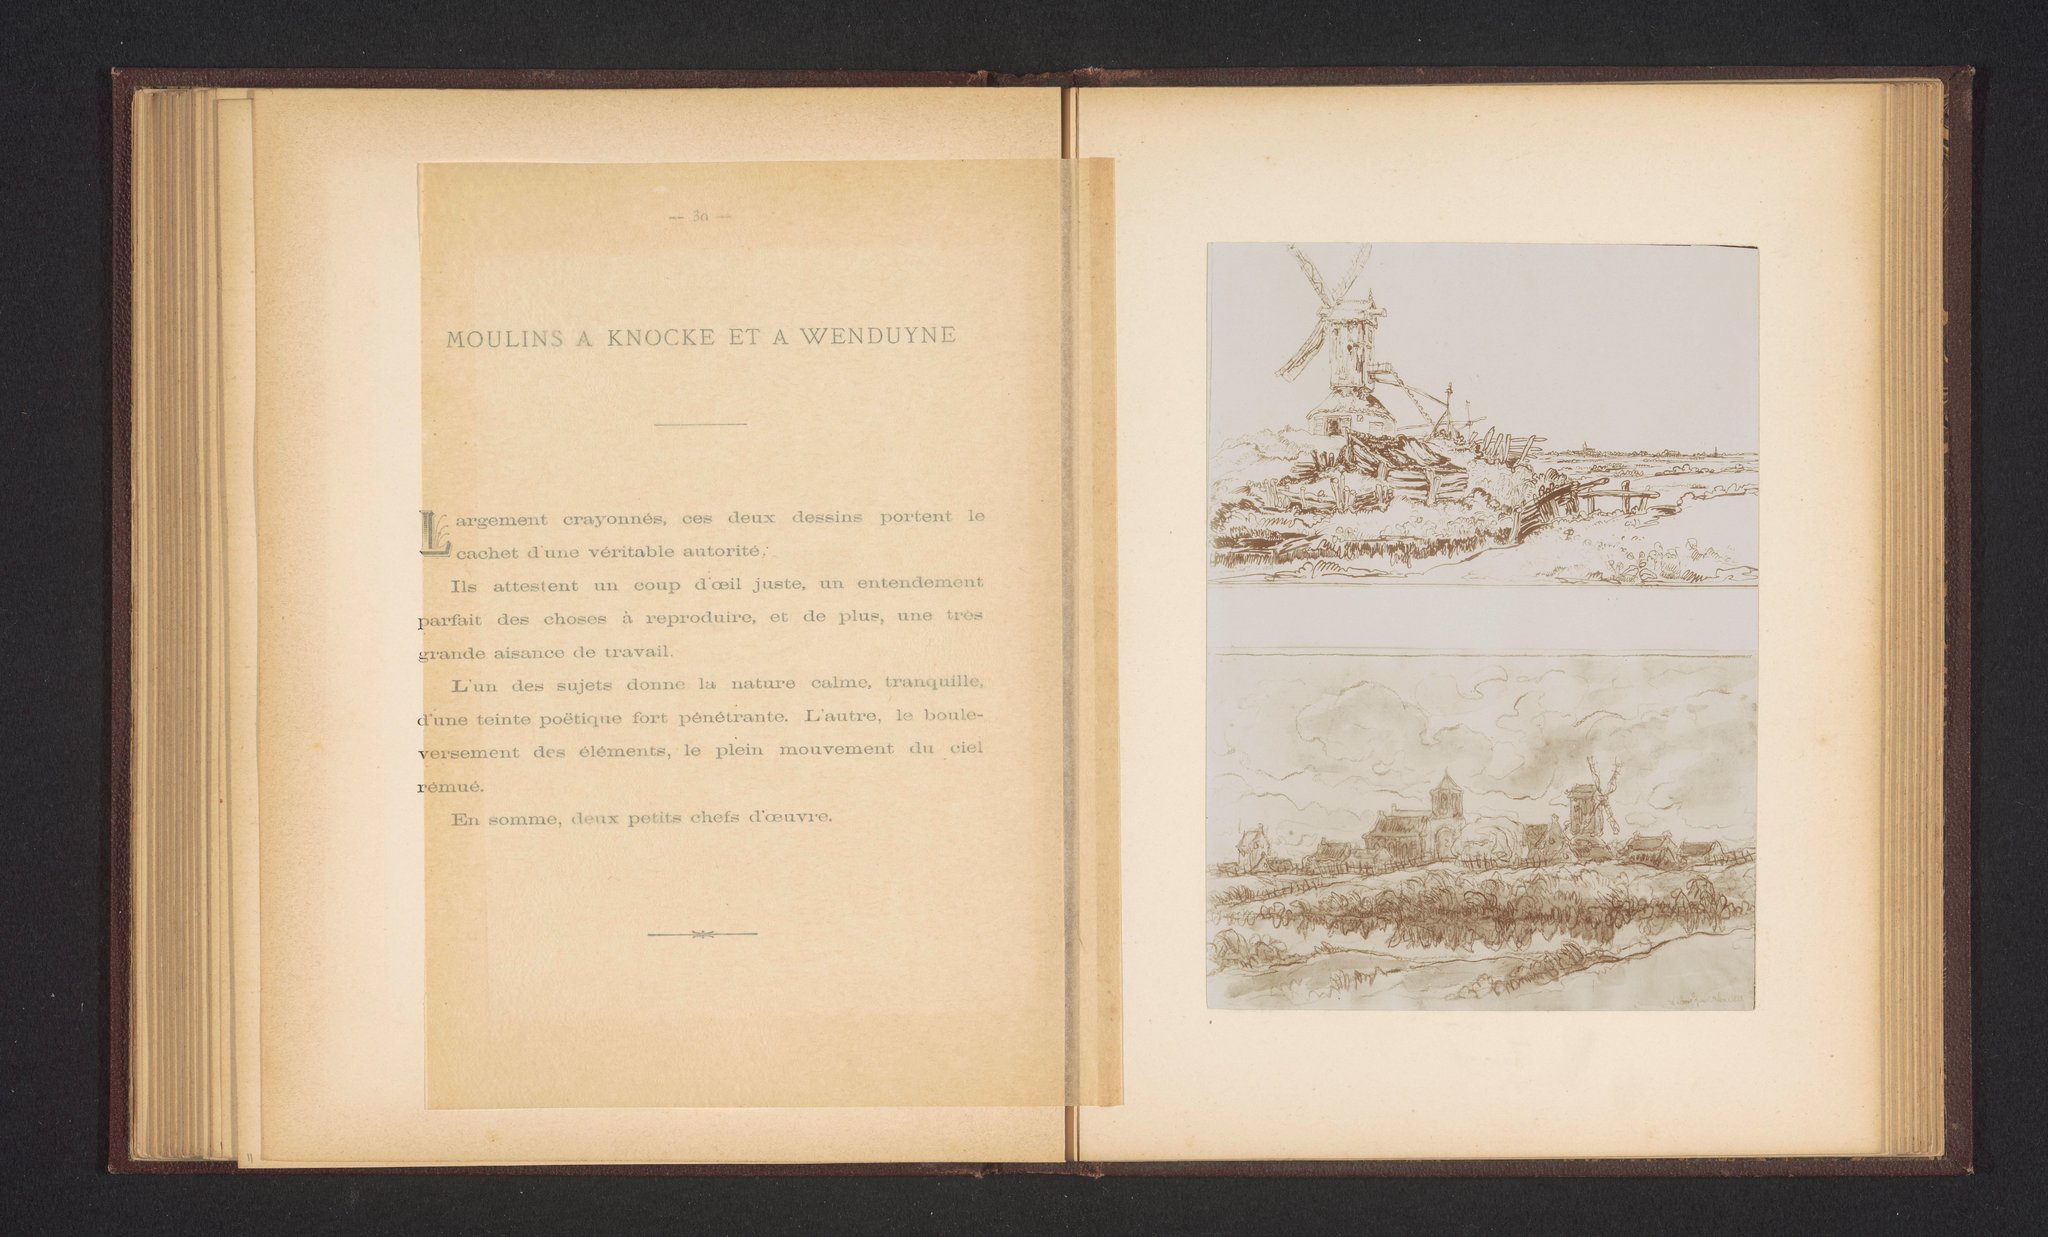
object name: photograph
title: Fotoreproductie van twee tekeningen van molens in een landschap door Willem Linnig (II)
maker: alexandre van antro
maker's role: painter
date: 1891-1896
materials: photographic support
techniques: collodion silver print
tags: windmill in landscape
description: Boven een molen in een landschap bij Knokke in België, onder een molen in een landschap bij Wenduine in België.